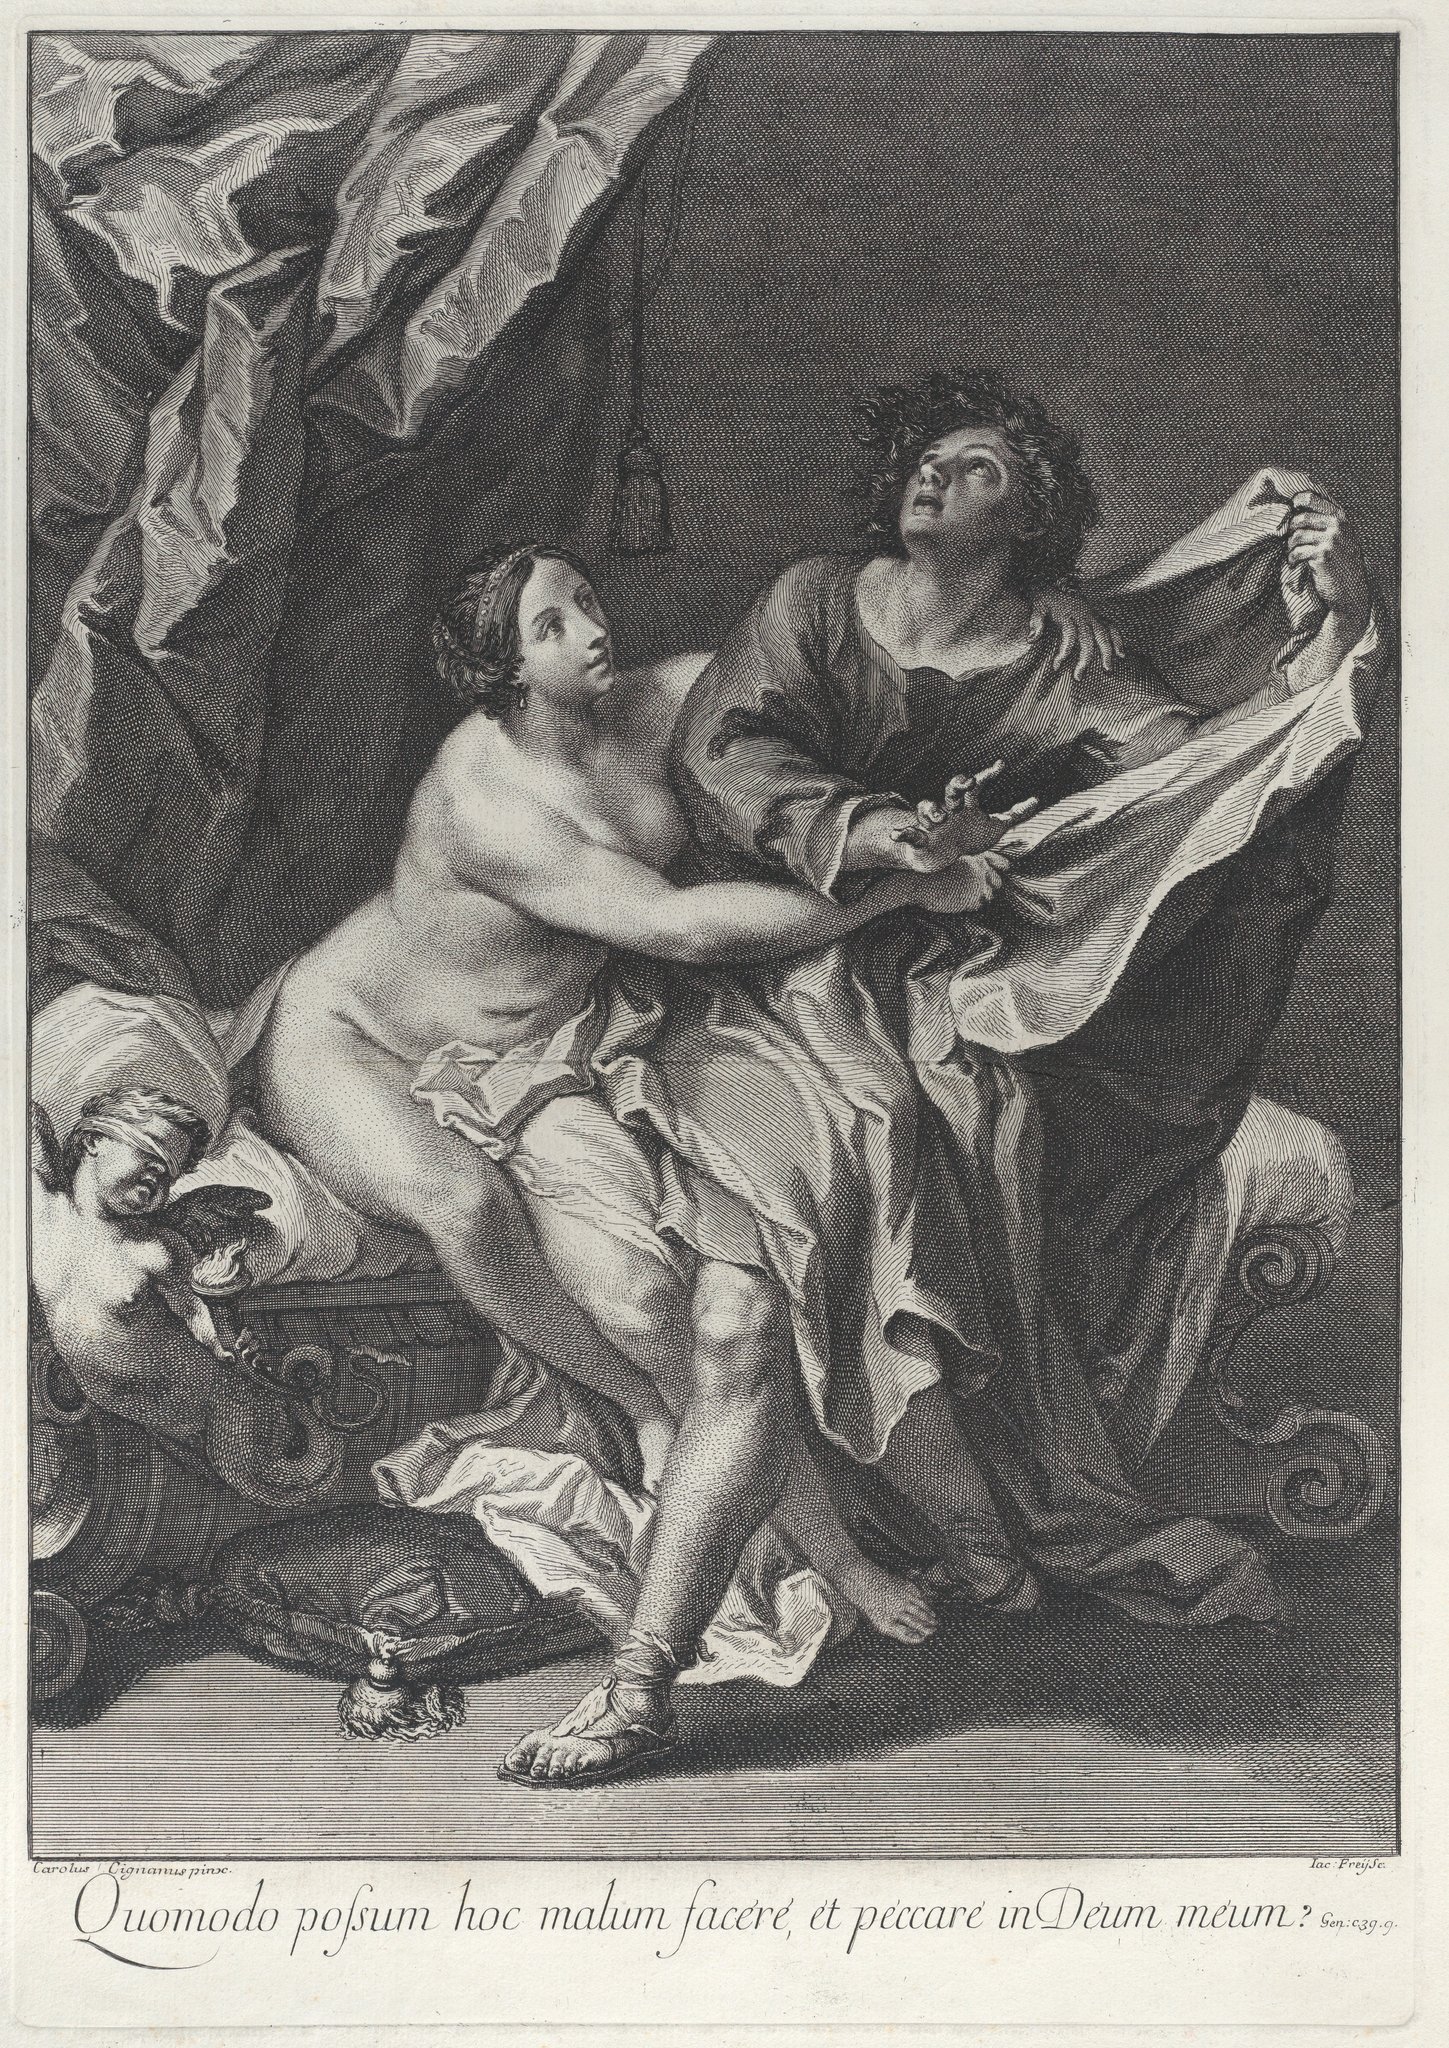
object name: print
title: Joseph and Potiphar's wife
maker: johann jakob frey the elder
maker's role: artist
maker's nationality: swiss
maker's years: 1681-1752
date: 1700-1752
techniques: etching